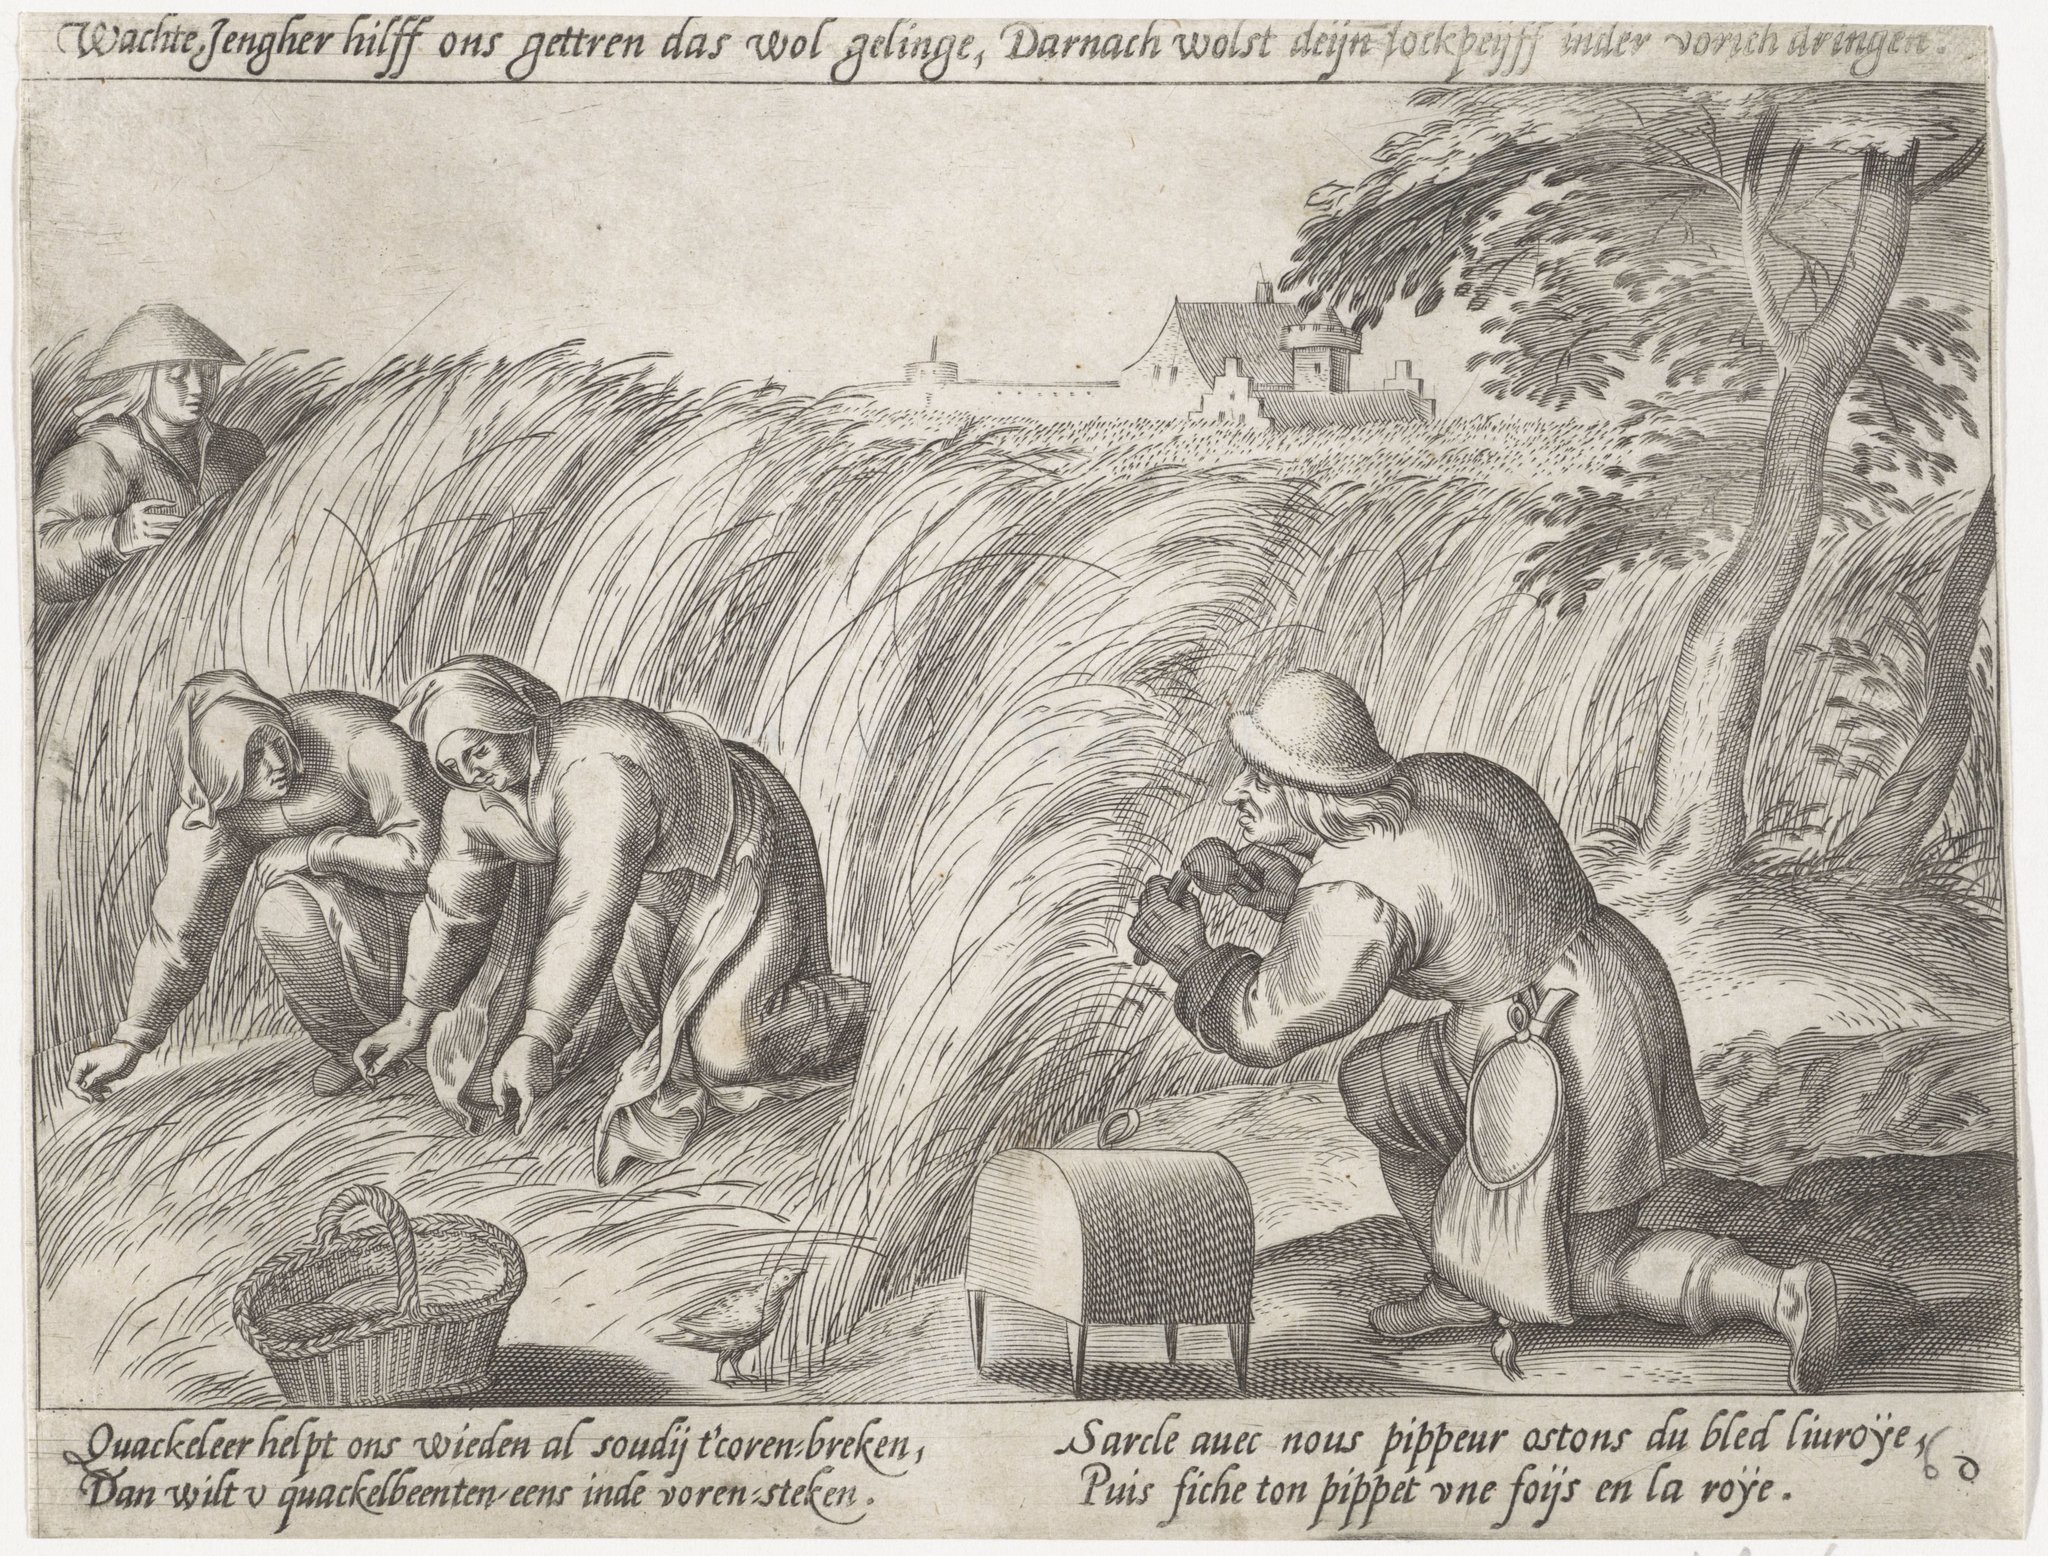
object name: print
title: Onkruid wieden op het land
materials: paper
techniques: engraving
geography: antwerp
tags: weeding, empty bird cage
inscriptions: collector's mark: Lugt 2228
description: Twee vrouwen wieden het onkruid op het korenveld. Een man bij een vogelkooi bespiedt hen. Op de prent een toelichting op de voorstelling in het Duits, het Nederlands en het Frans.